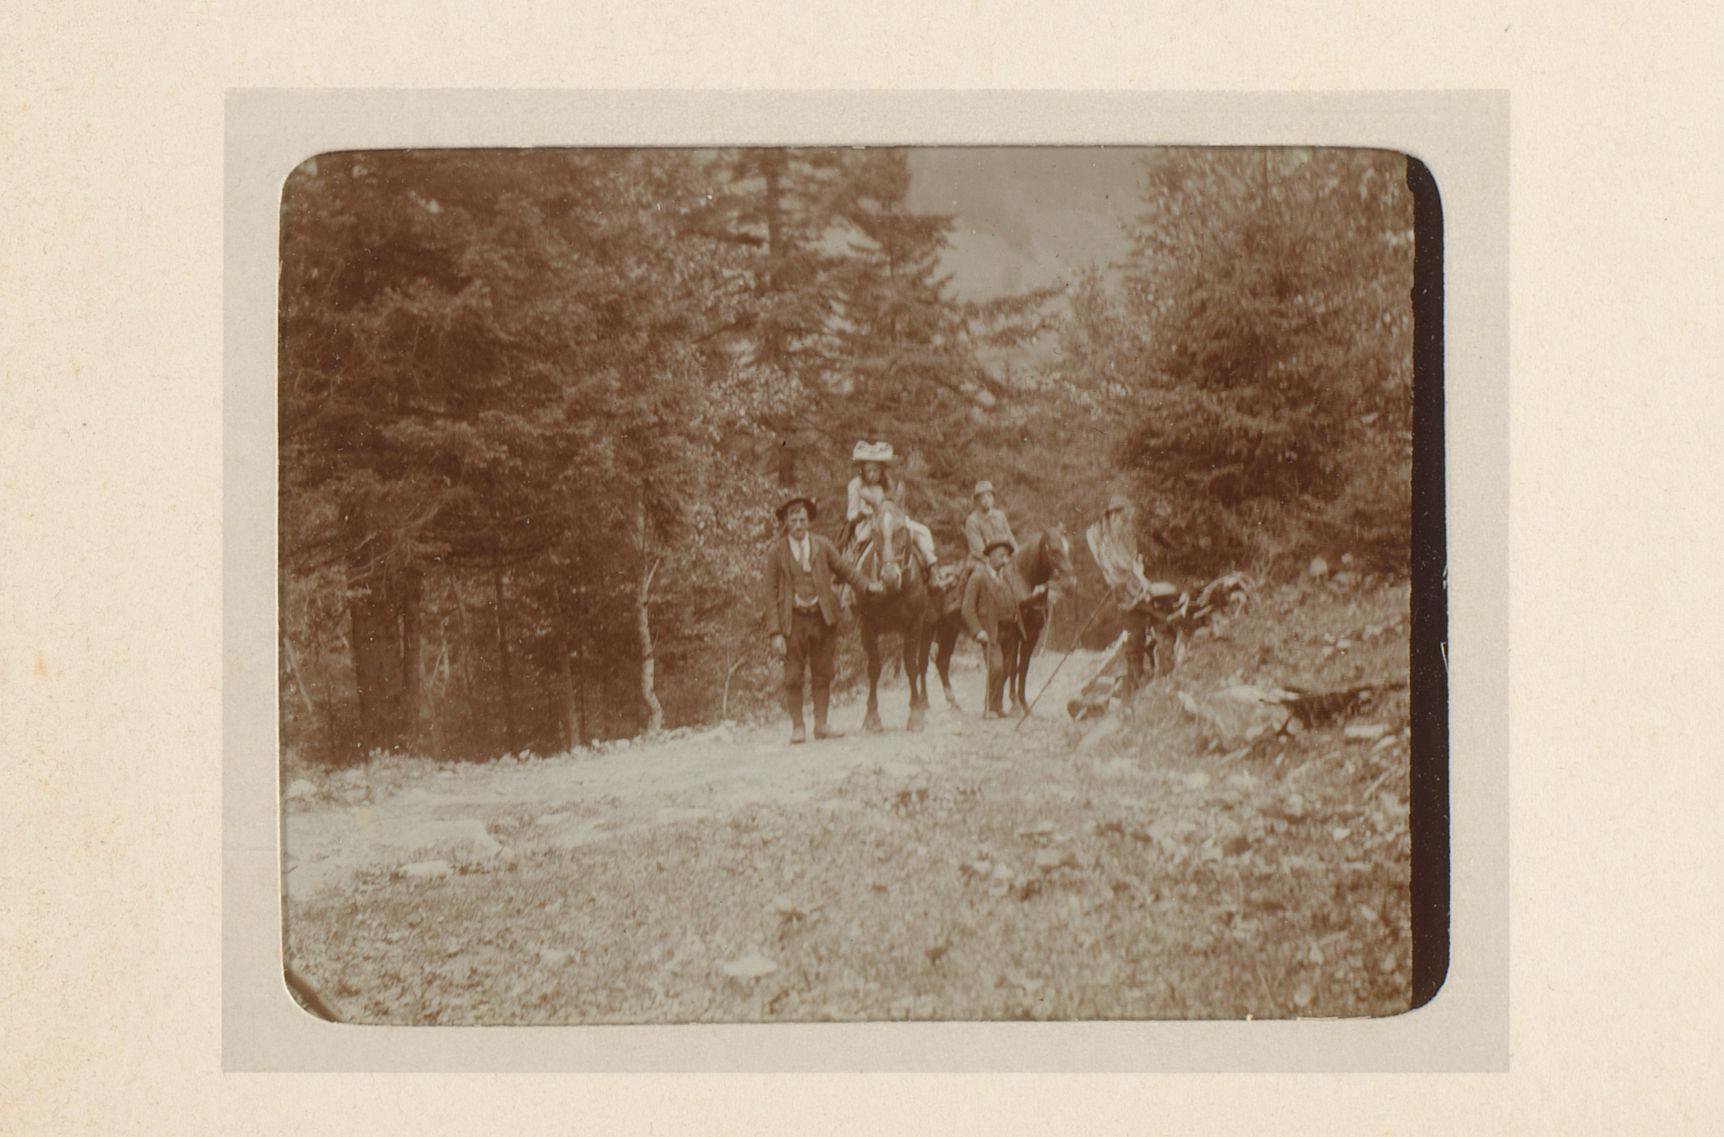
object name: album leaf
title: Gezelschap tijdens een rit te paard in de bergen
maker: liesbeth overhoff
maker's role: fotograaf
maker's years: 1895-1969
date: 1911-1912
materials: paper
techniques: gelatin silver print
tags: riding a horse, ass, or mule; rider, horseman, historical persons, mountains